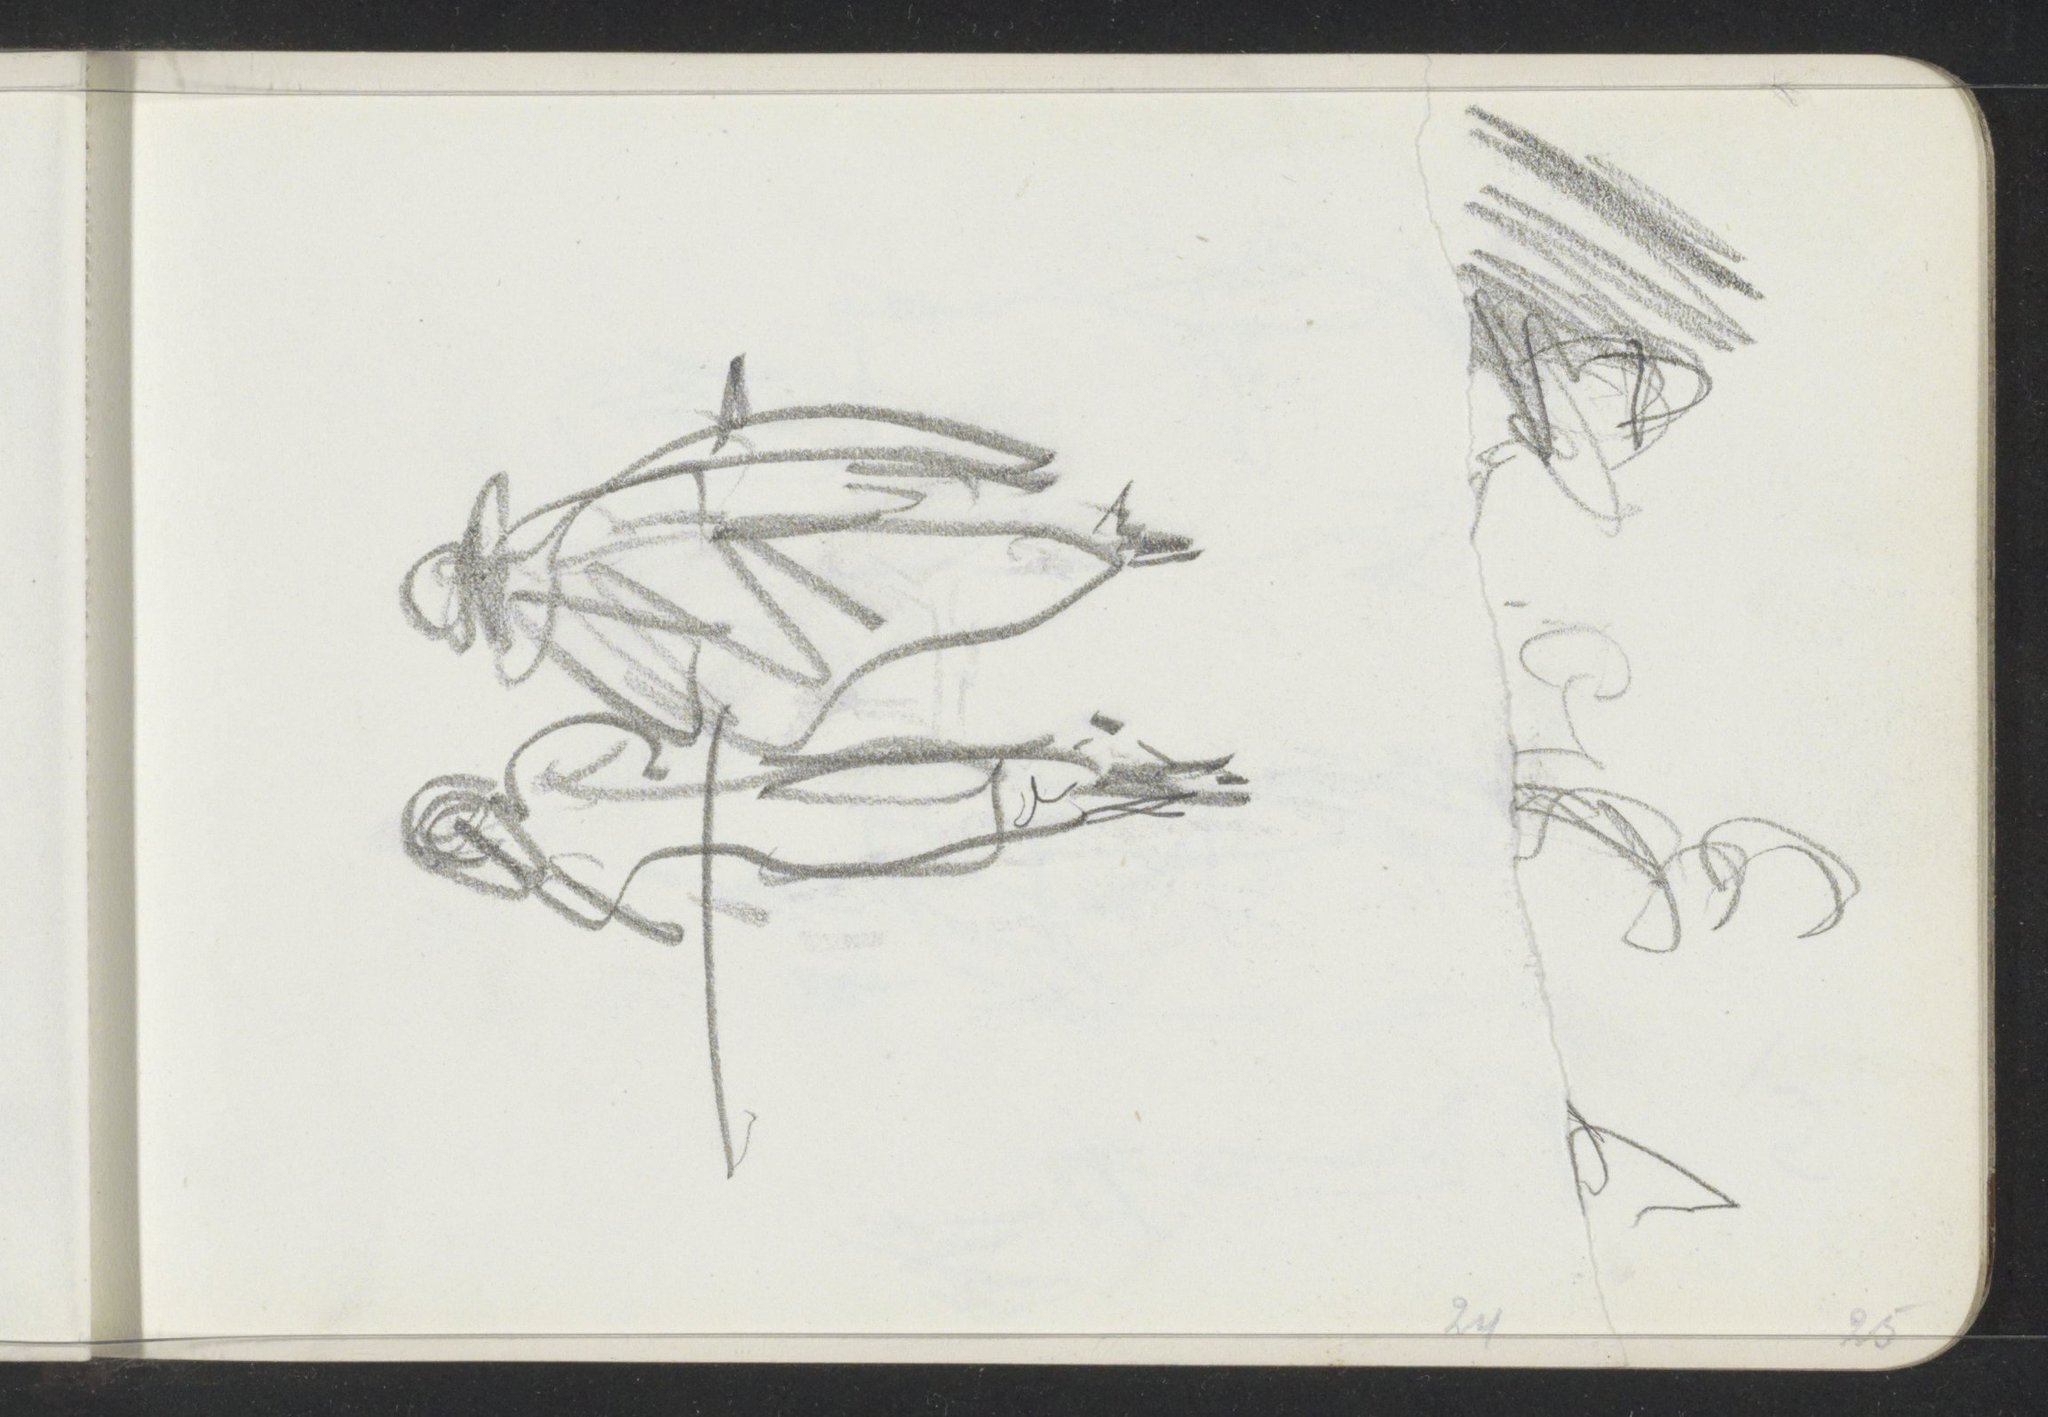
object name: sketchbook leaf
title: Twee vrouwen, op de rug gezien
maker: isaac israels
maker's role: draughtsman, painter, print maker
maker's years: 1865-1934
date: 1875-1934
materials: paper, pencil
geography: the hague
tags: adult woman (+ standing)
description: Blad 24 recto uit schetsboek LX met 33 bladen.